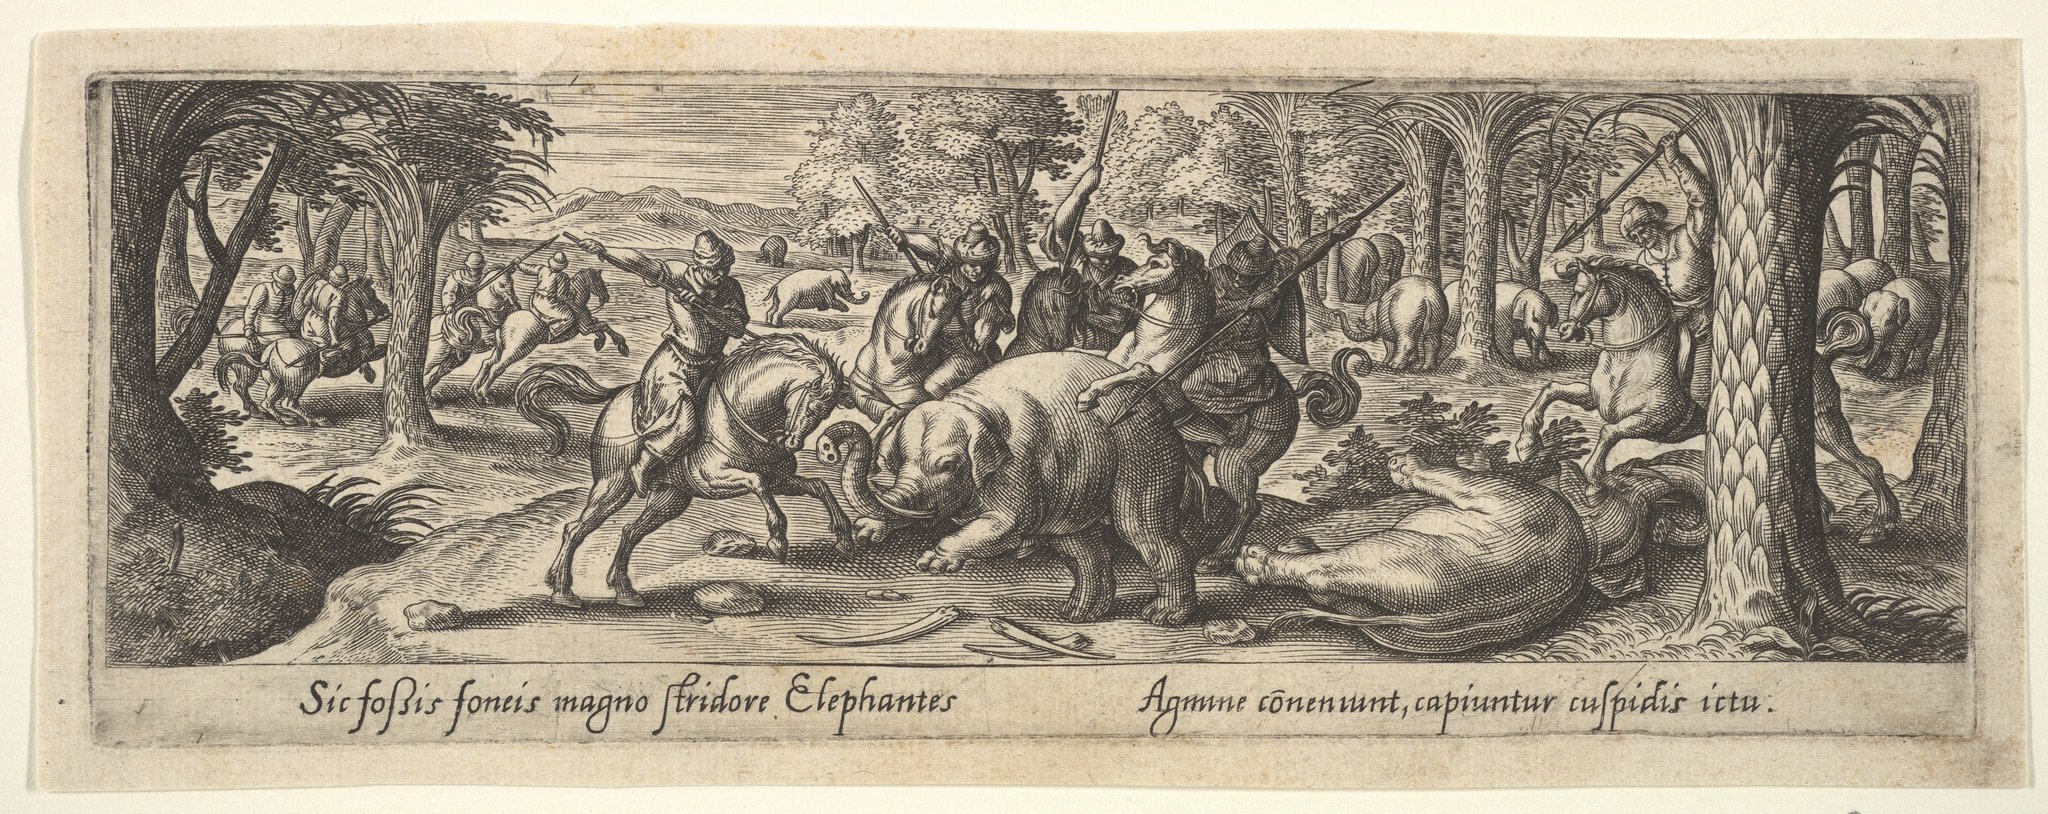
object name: print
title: 1 of 8 plates on Hunting and Fishing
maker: hans bol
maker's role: artist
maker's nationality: netherlandish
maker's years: 1534-1593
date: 1580-1620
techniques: engraving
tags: men,hunting,elephants,horses